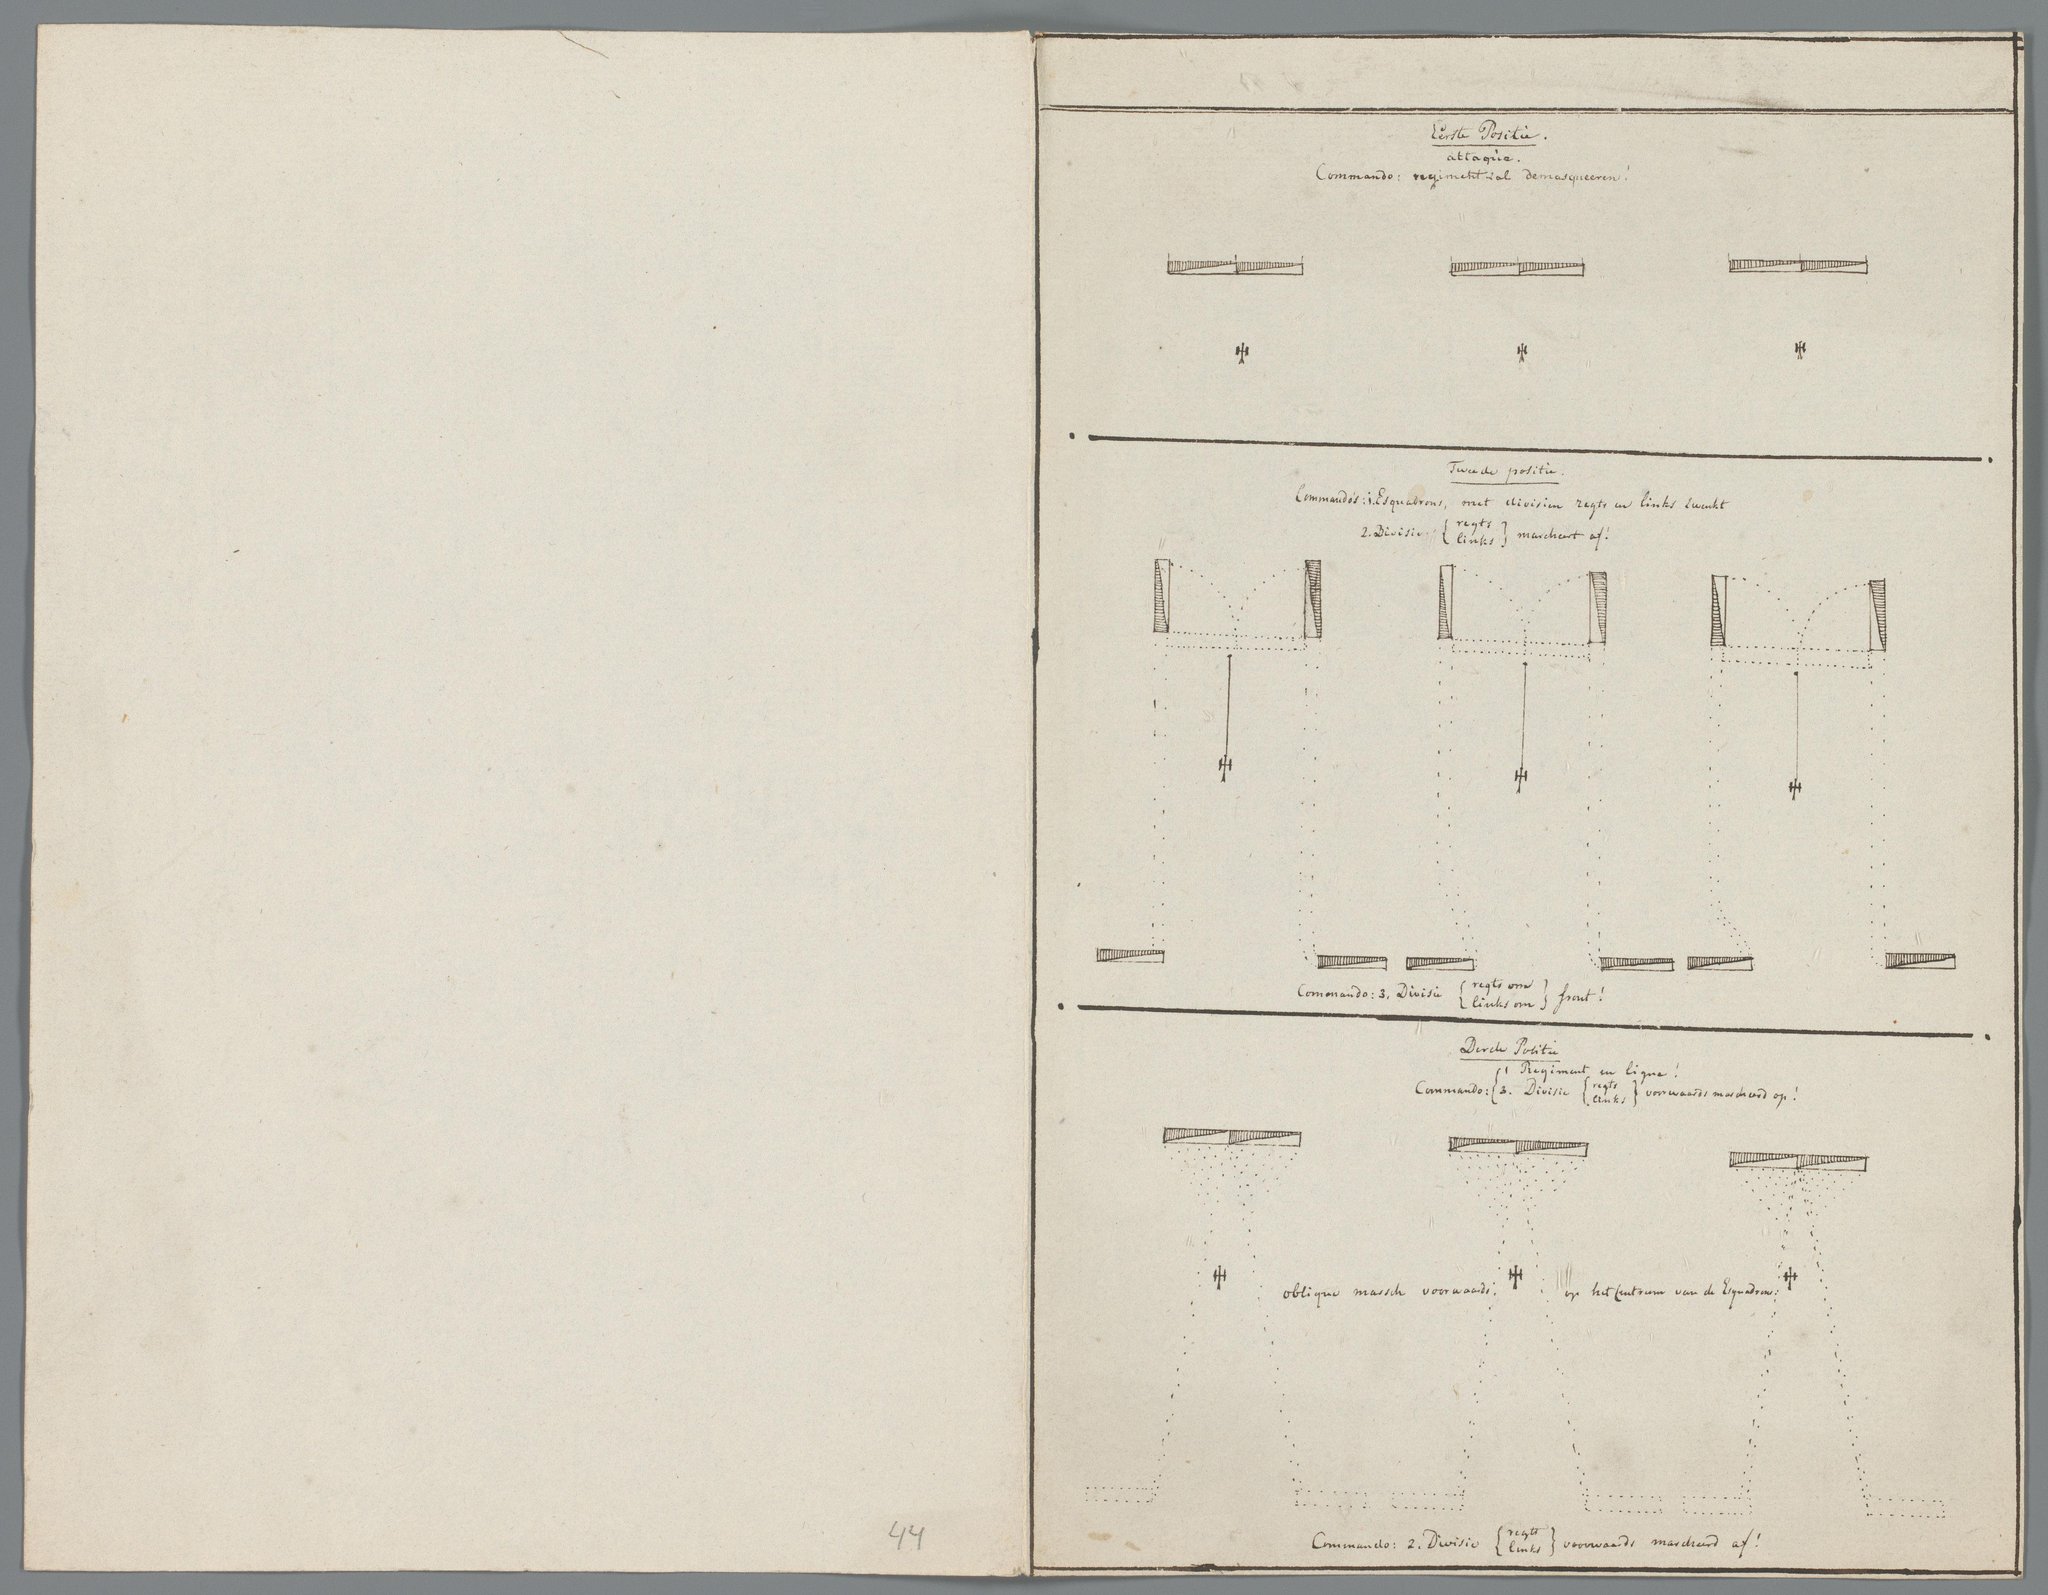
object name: drawing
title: Oefeningen van het bataljon, ca. 1799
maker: hendrik van der poth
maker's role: draughtsman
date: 1799-1803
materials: paper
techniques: writing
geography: netherlands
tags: manoeuvre ~ military training, delft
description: Dubbelgevouwen blad met op voorzijde drie schetsen van manoeuvres en commando's van de Bataafsche Gewapende Burgermacht te Delft, ca. 1799.